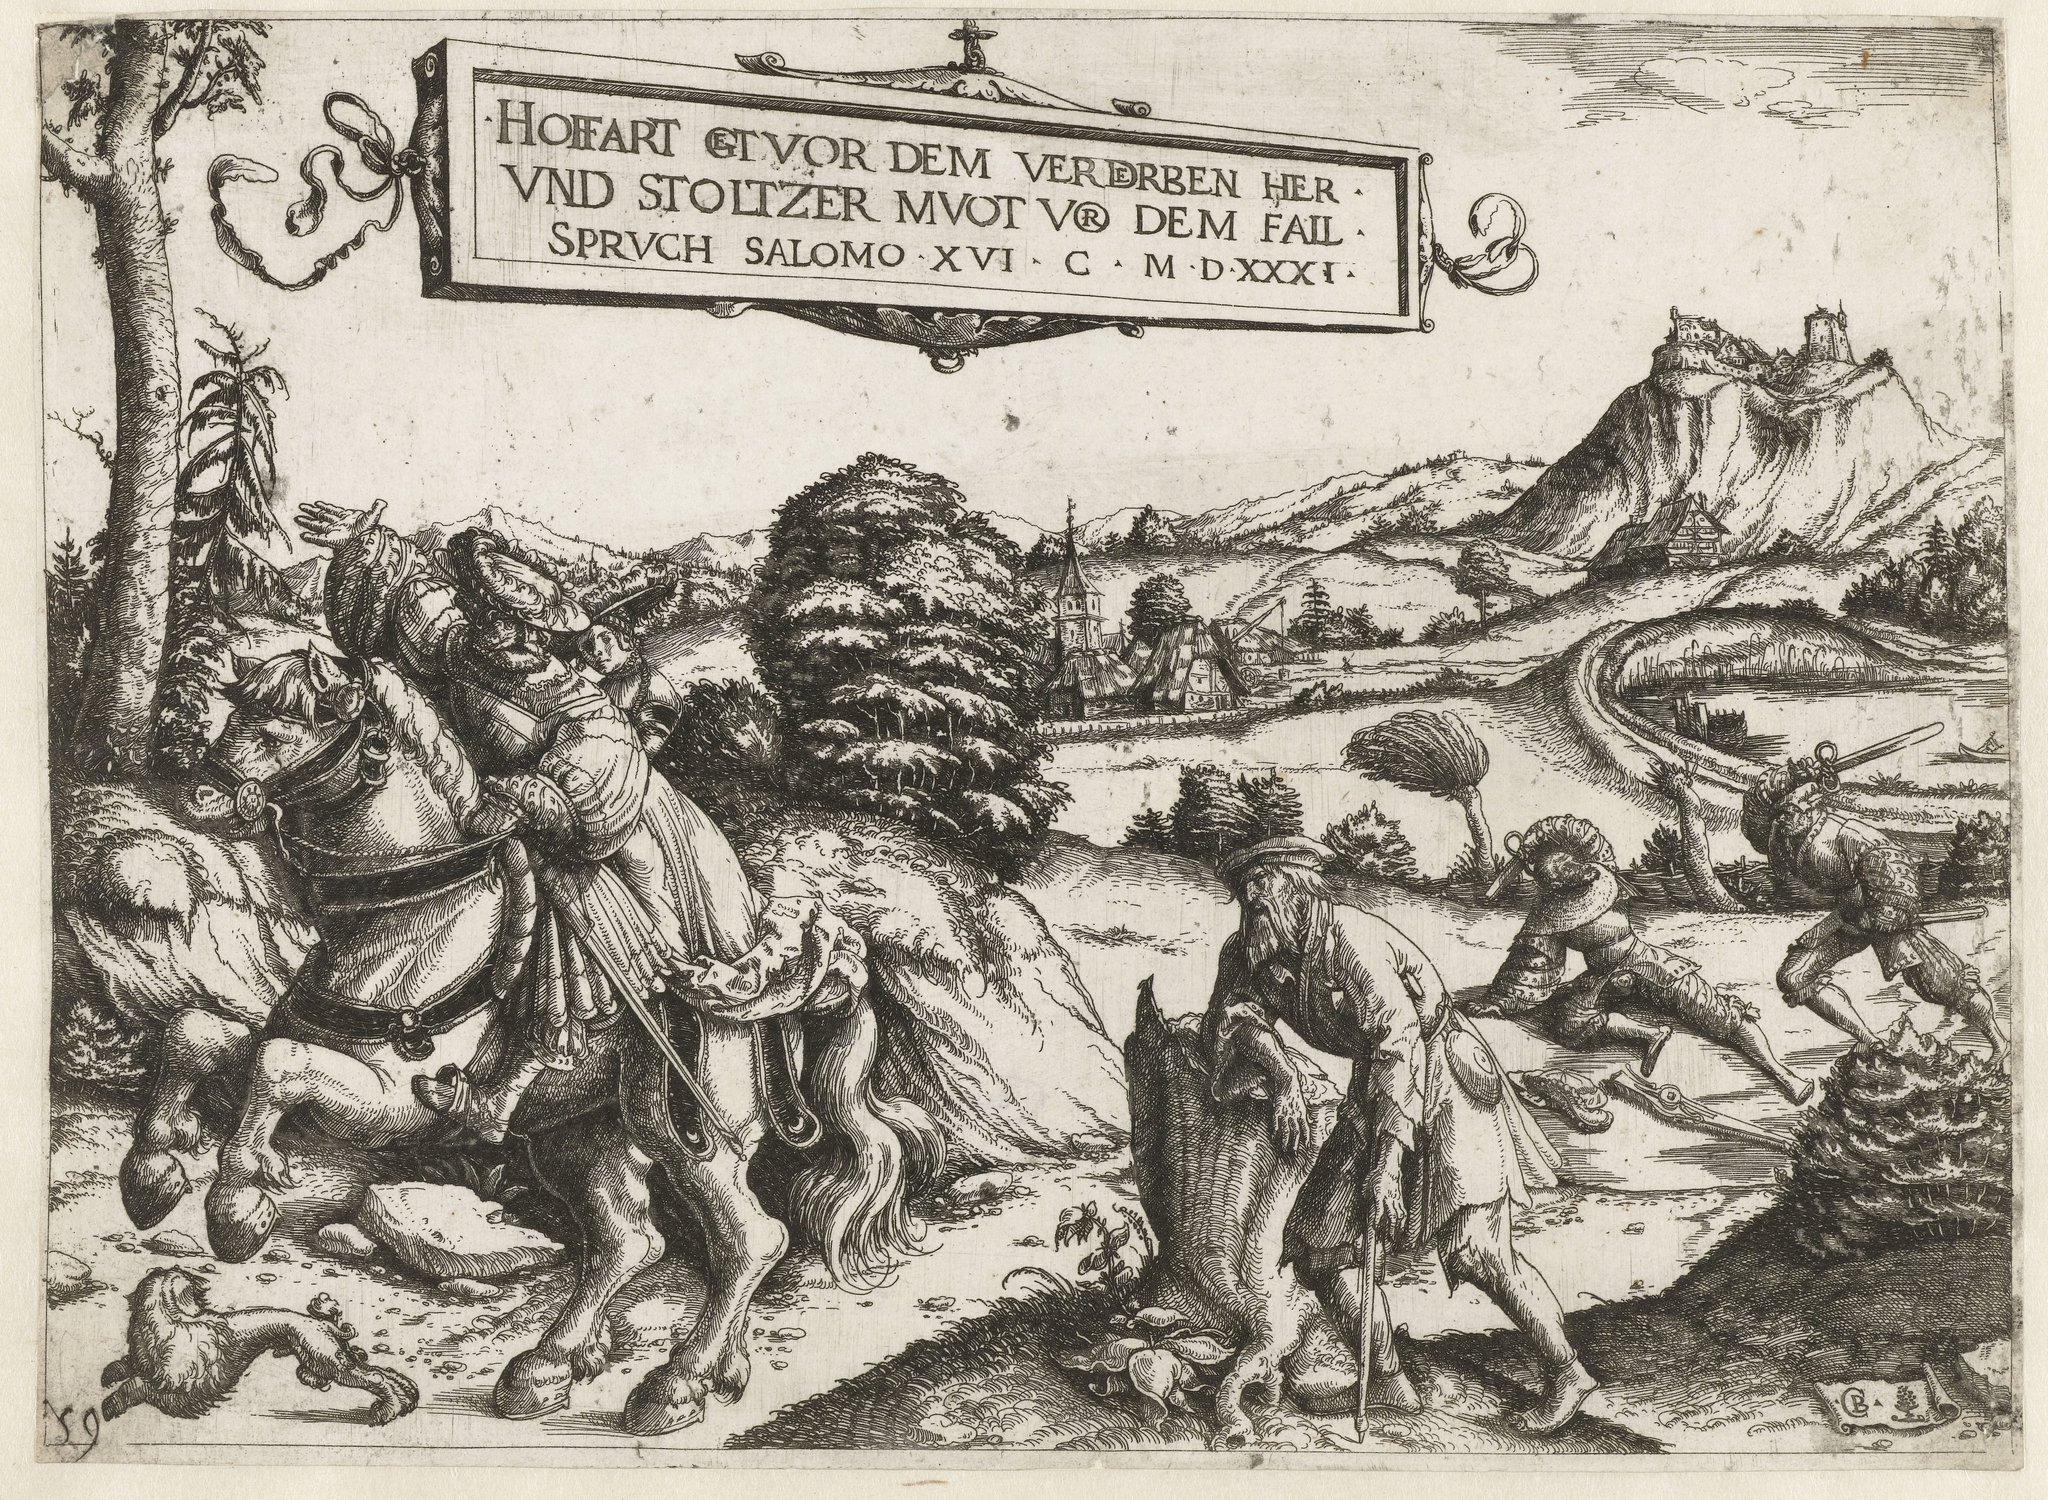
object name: print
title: Hooghartigheid en Hoogmoed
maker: monogrammist cb met boom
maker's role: print maker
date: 1531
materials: paper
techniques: etching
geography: germany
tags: the book of proverbs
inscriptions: collector's mark: Lugt 2228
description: Verbeelding van de spreuk "Hooghartigheid gaat vooraf aan ellende, hoogmoed komt voor de val" (Spr. 16:18). Een landschap met een echtpaar in weelderige kledij te paard, zij rijden een bedelaar leunend tegen een boomstronk voorbij. Daarachter een gevecht tussen twee mannen. Bovenaan een cartouche met de spreuk in het Duits.